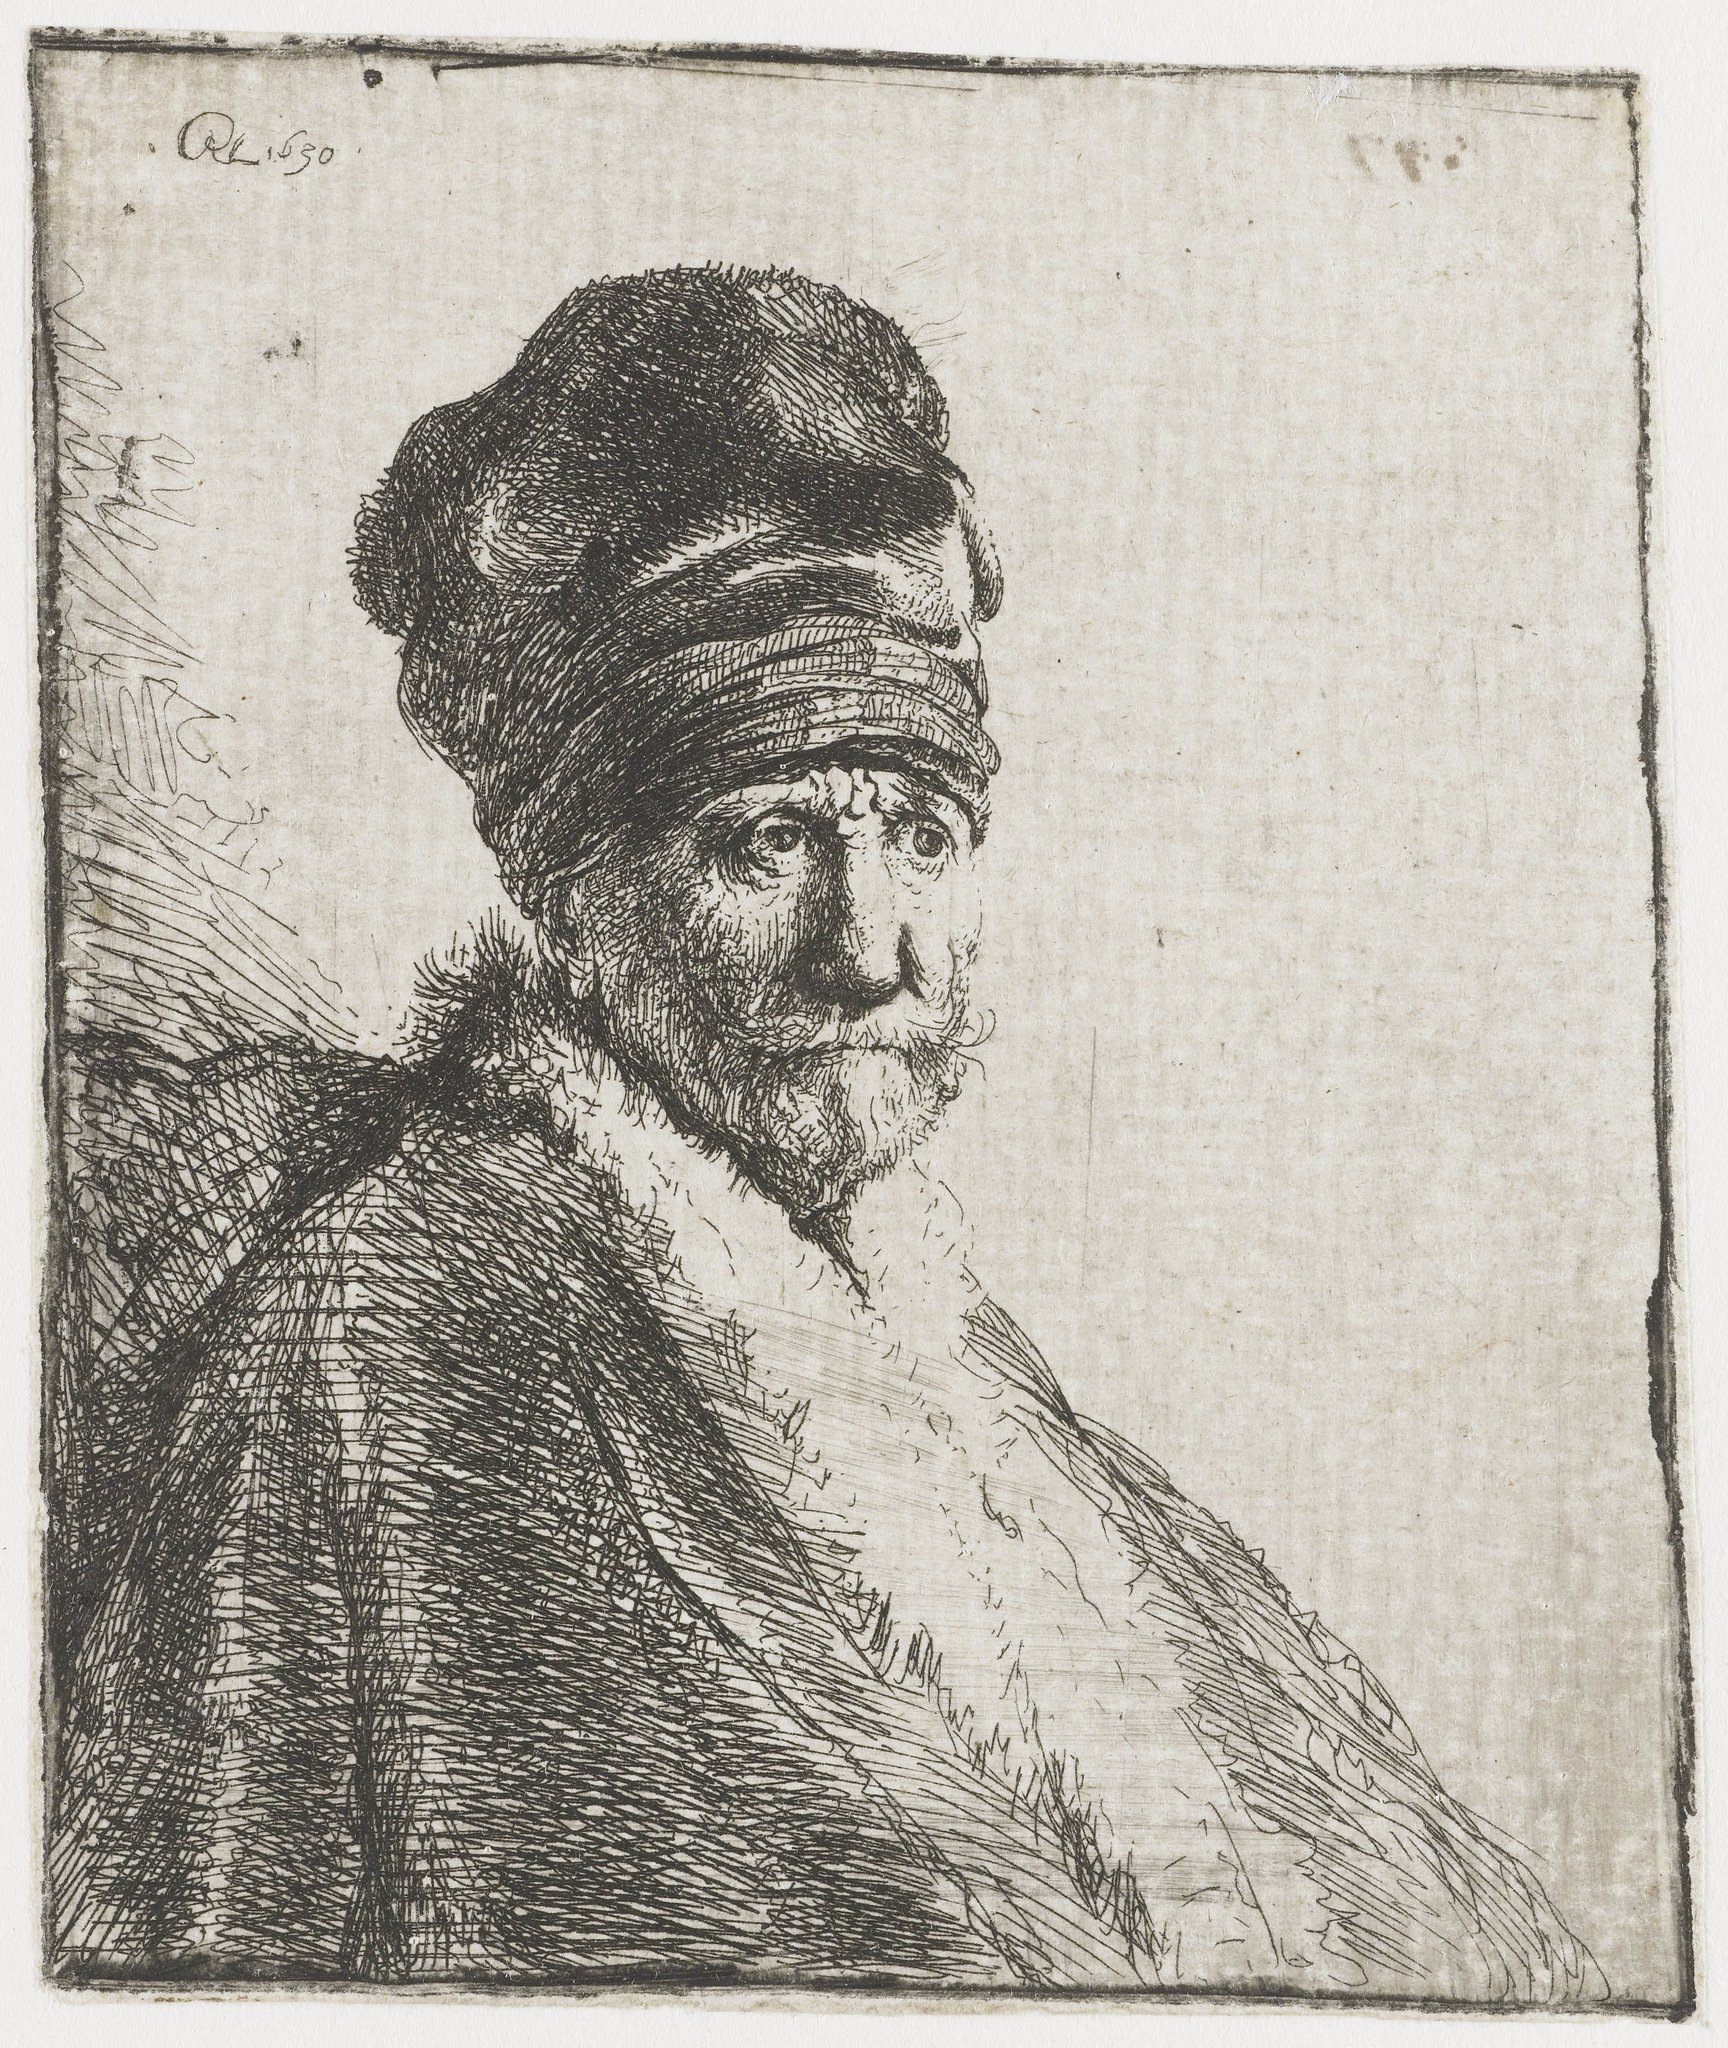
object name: print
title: Bust of a man wearing a high cap, three-quarters right: the artist's father (?)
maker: rembrandt van rijn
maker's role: draughtsman, painter, print maker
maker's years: 1606-1669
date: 1630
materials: paper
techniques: etching, intaglio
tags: leiden, can hook, head-gear: cap (+ men's clothes)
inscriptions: monogram and date: ‘RHL 1630’, collector's mark: Lugt 240